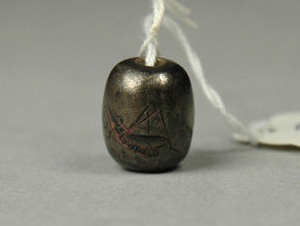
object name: ojime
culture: japanese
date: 1801-1900